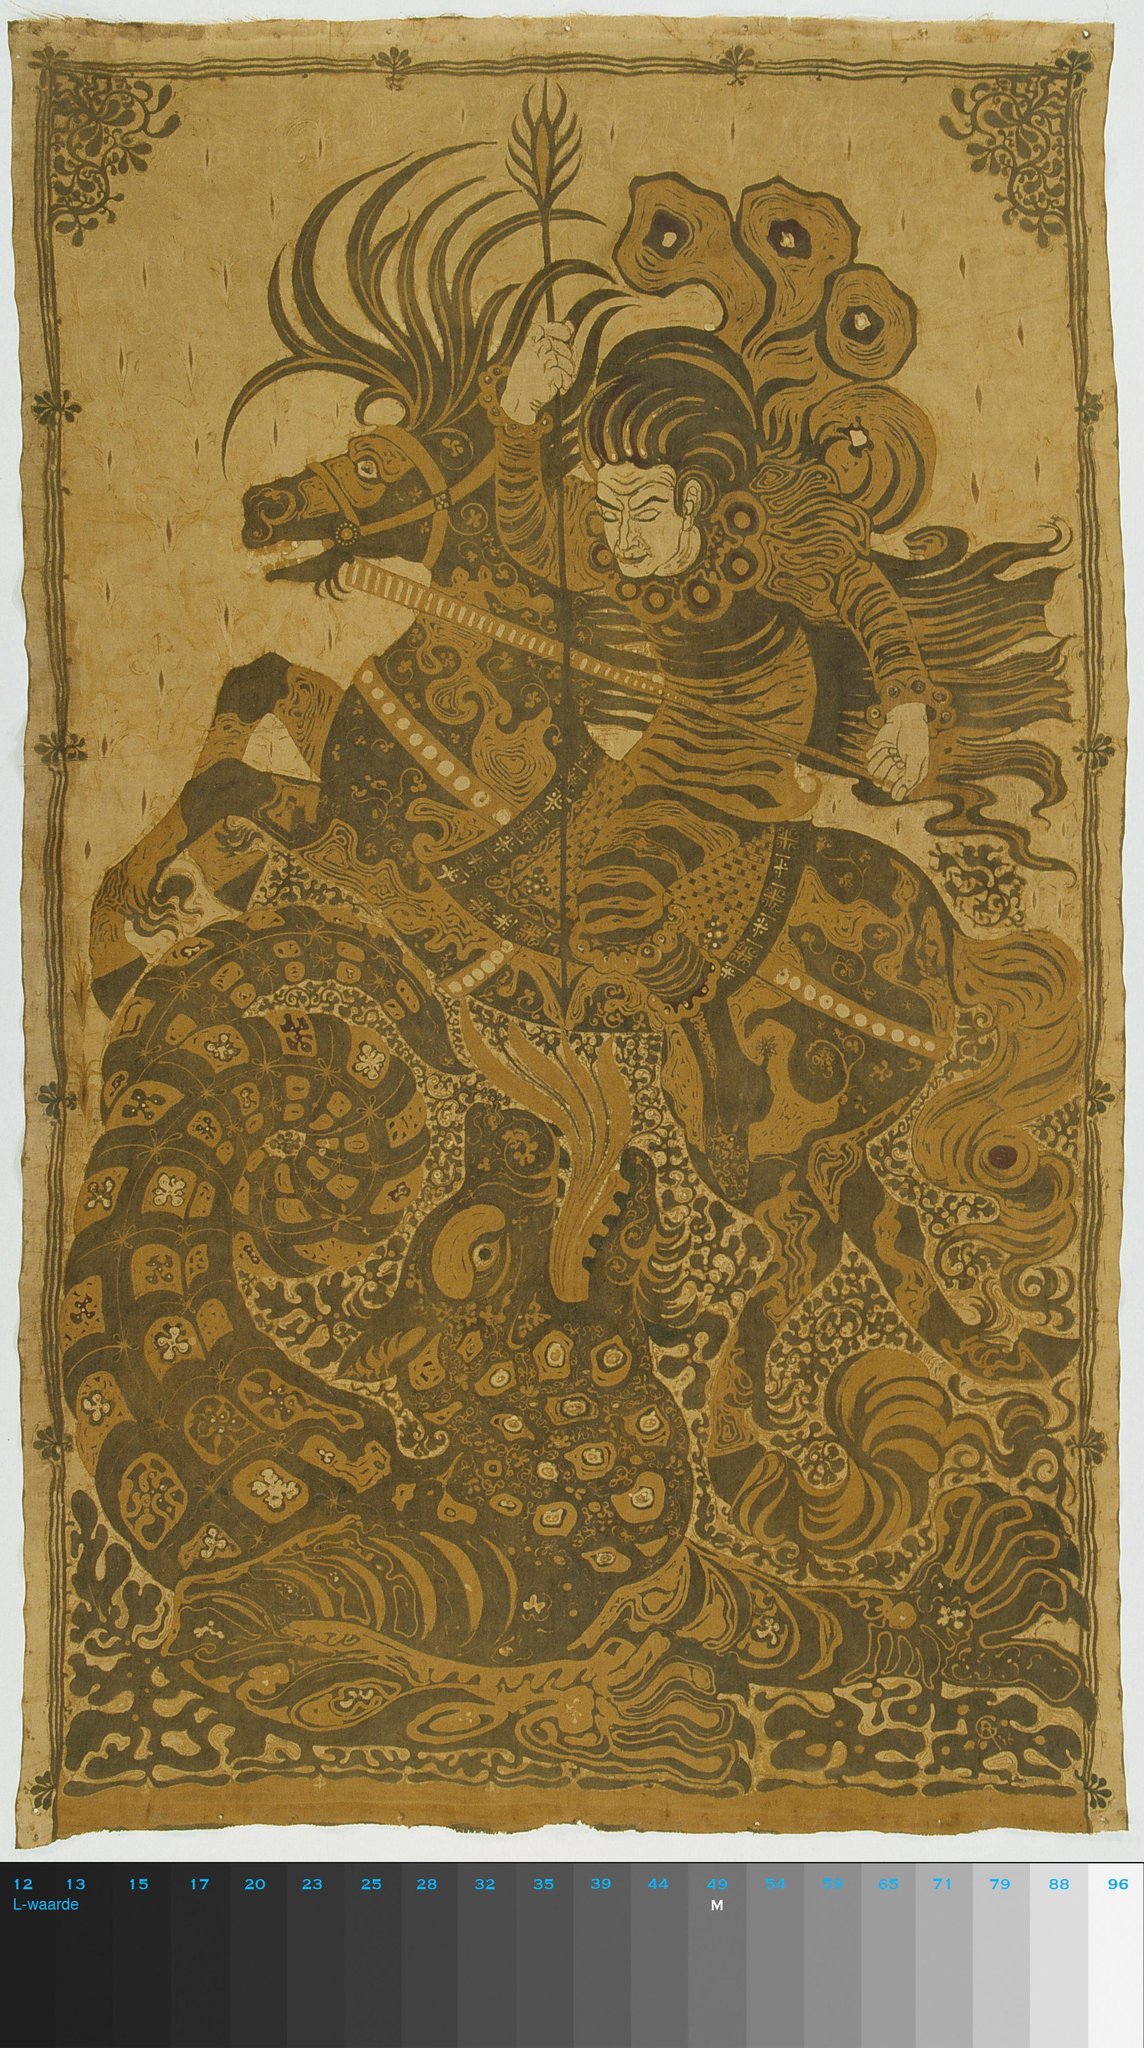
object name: tapestry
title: Wandkleed met Joris en de draak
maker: roelf gerbrands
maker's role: designer, draughtsman, print maker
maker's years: 1891-1954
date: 1916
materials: linen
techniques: batik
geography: netherlands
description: Wandkleed van batik op linnen met de voorstelling van een ruiter (St. Joris) in gevecht met de draak, in zwart en bruin met goudkleurige accenten, op crèmekleurige ondergrond. Gemerkt: R.G. '16 (Roelf Gerbrands, 1916).